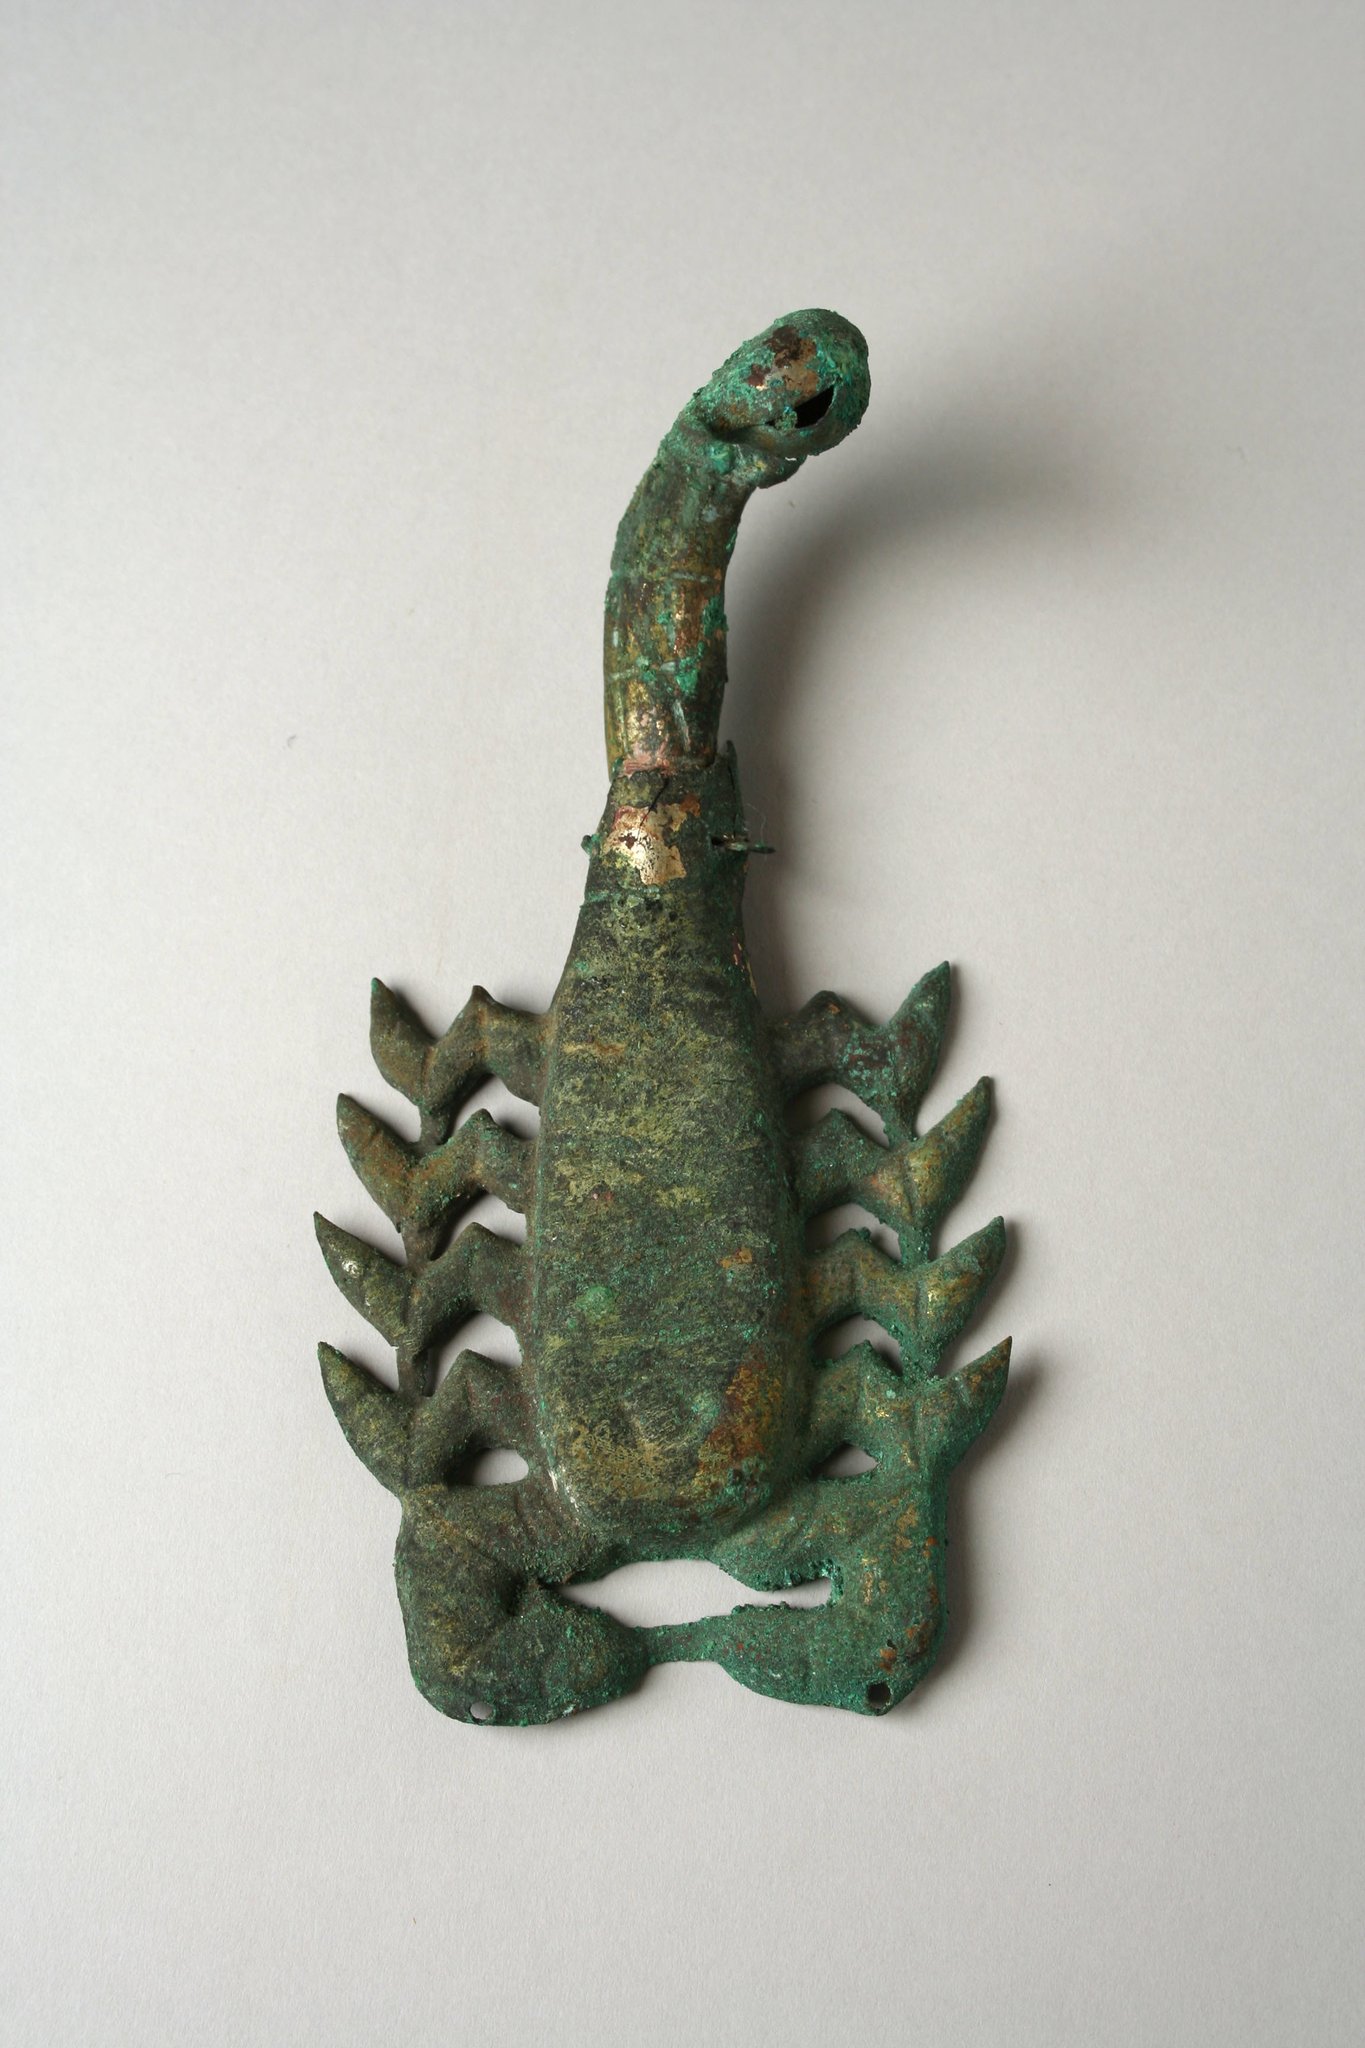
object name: ornament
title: Scorpion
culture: moche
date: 501-700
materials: gilt copper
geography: peru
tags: scorpions